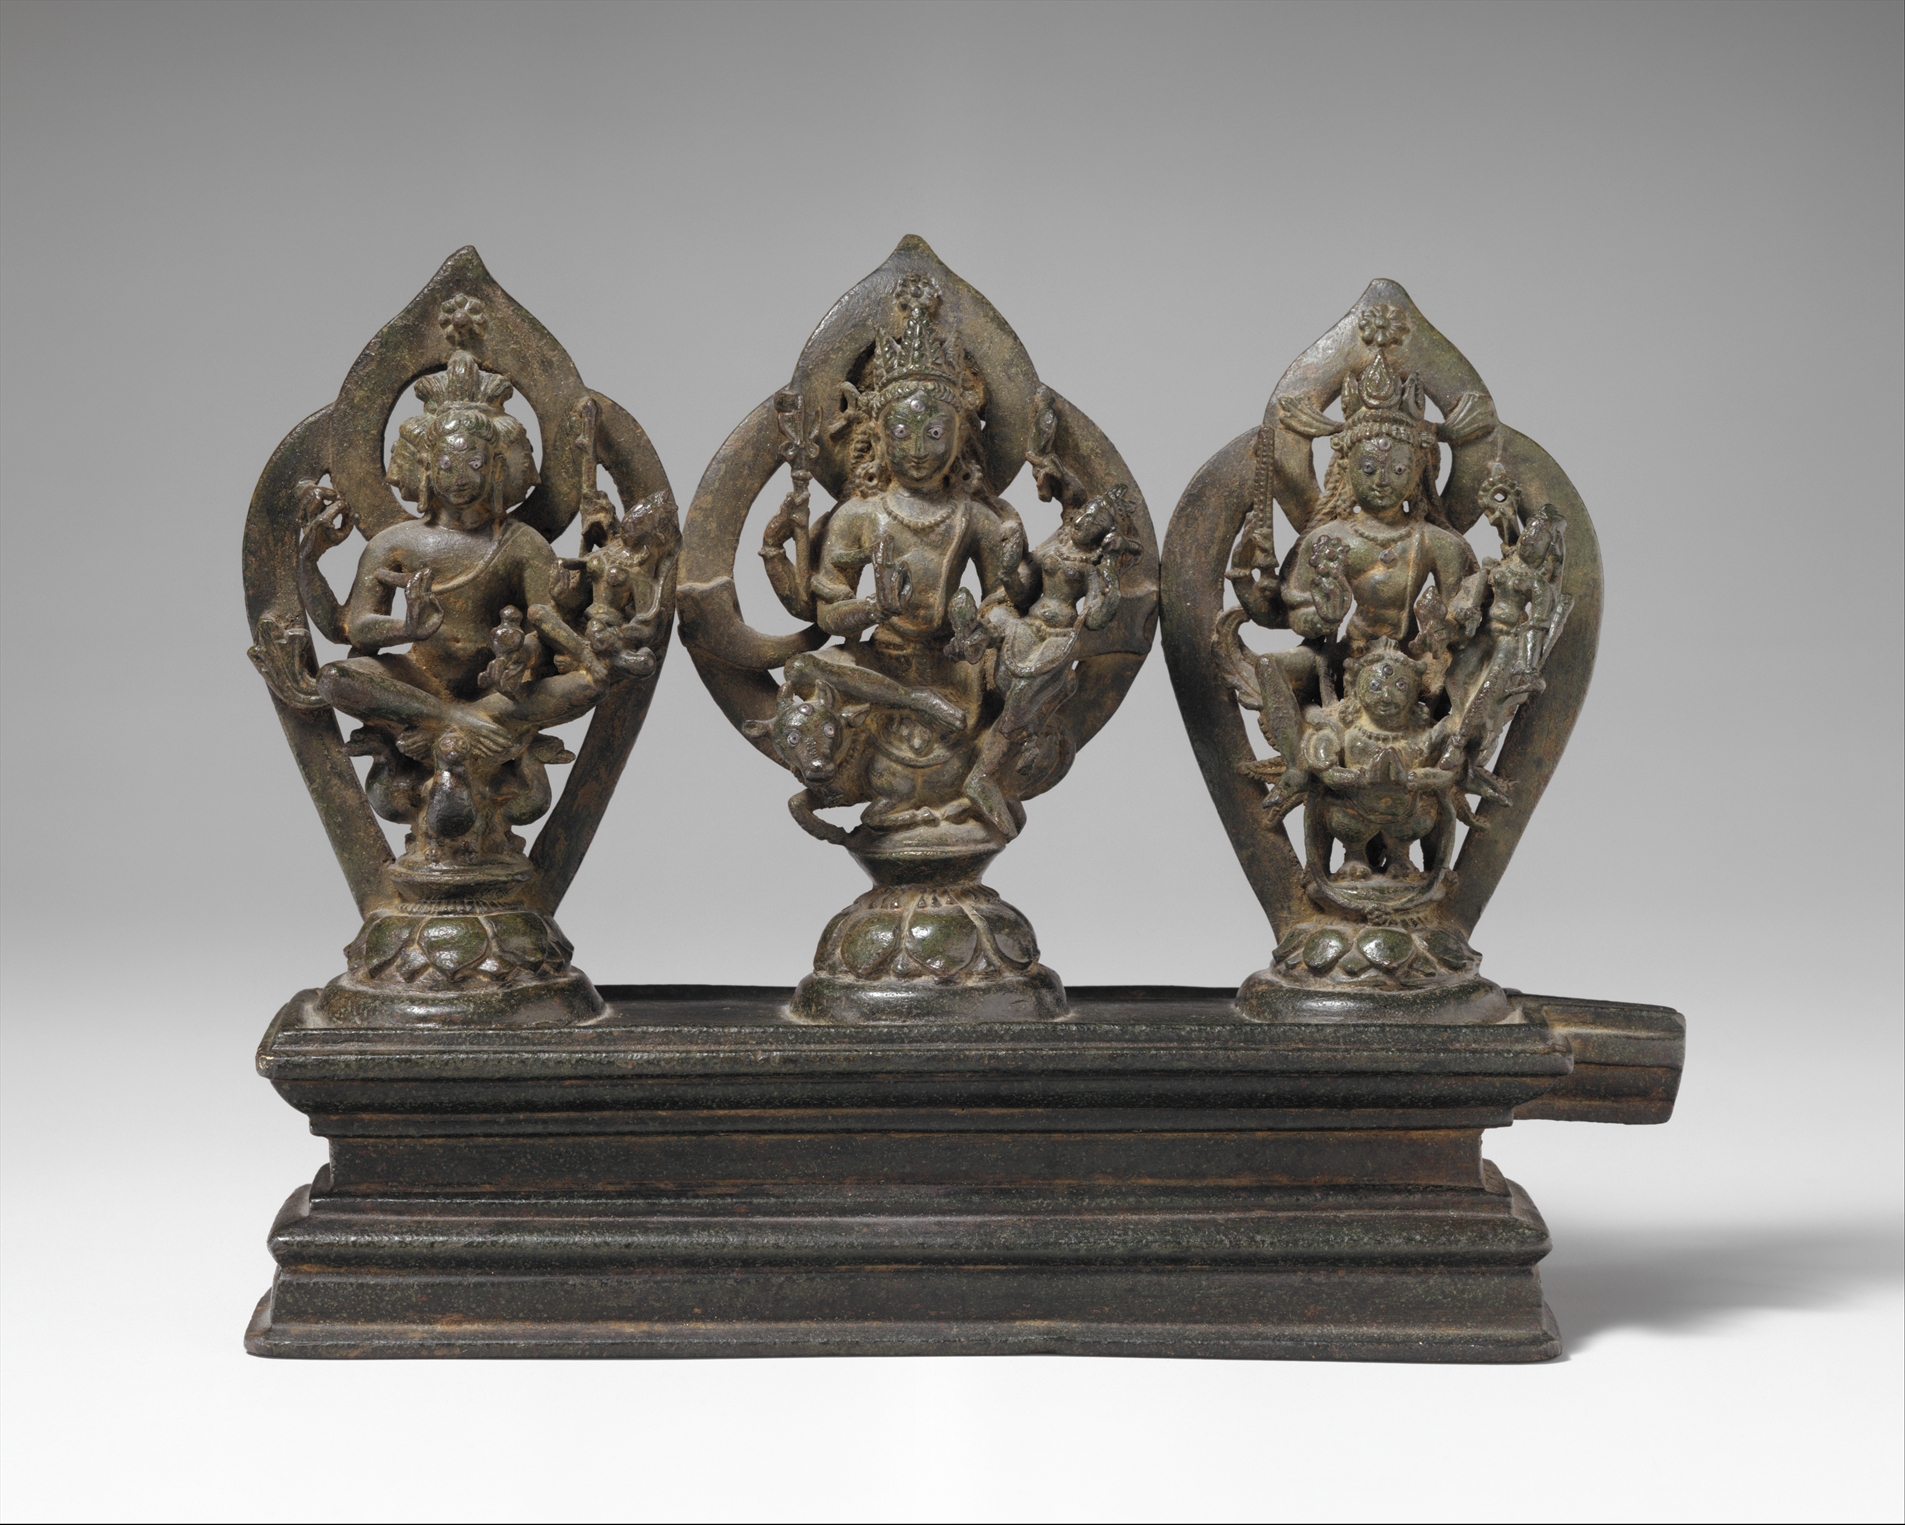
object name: figure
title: Brahma, Shiva, and Vishnu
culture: pakistani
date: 801-900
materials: bronze, silver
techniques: inlay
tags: swat valley,brahma,shiva,vishnu,hinduism